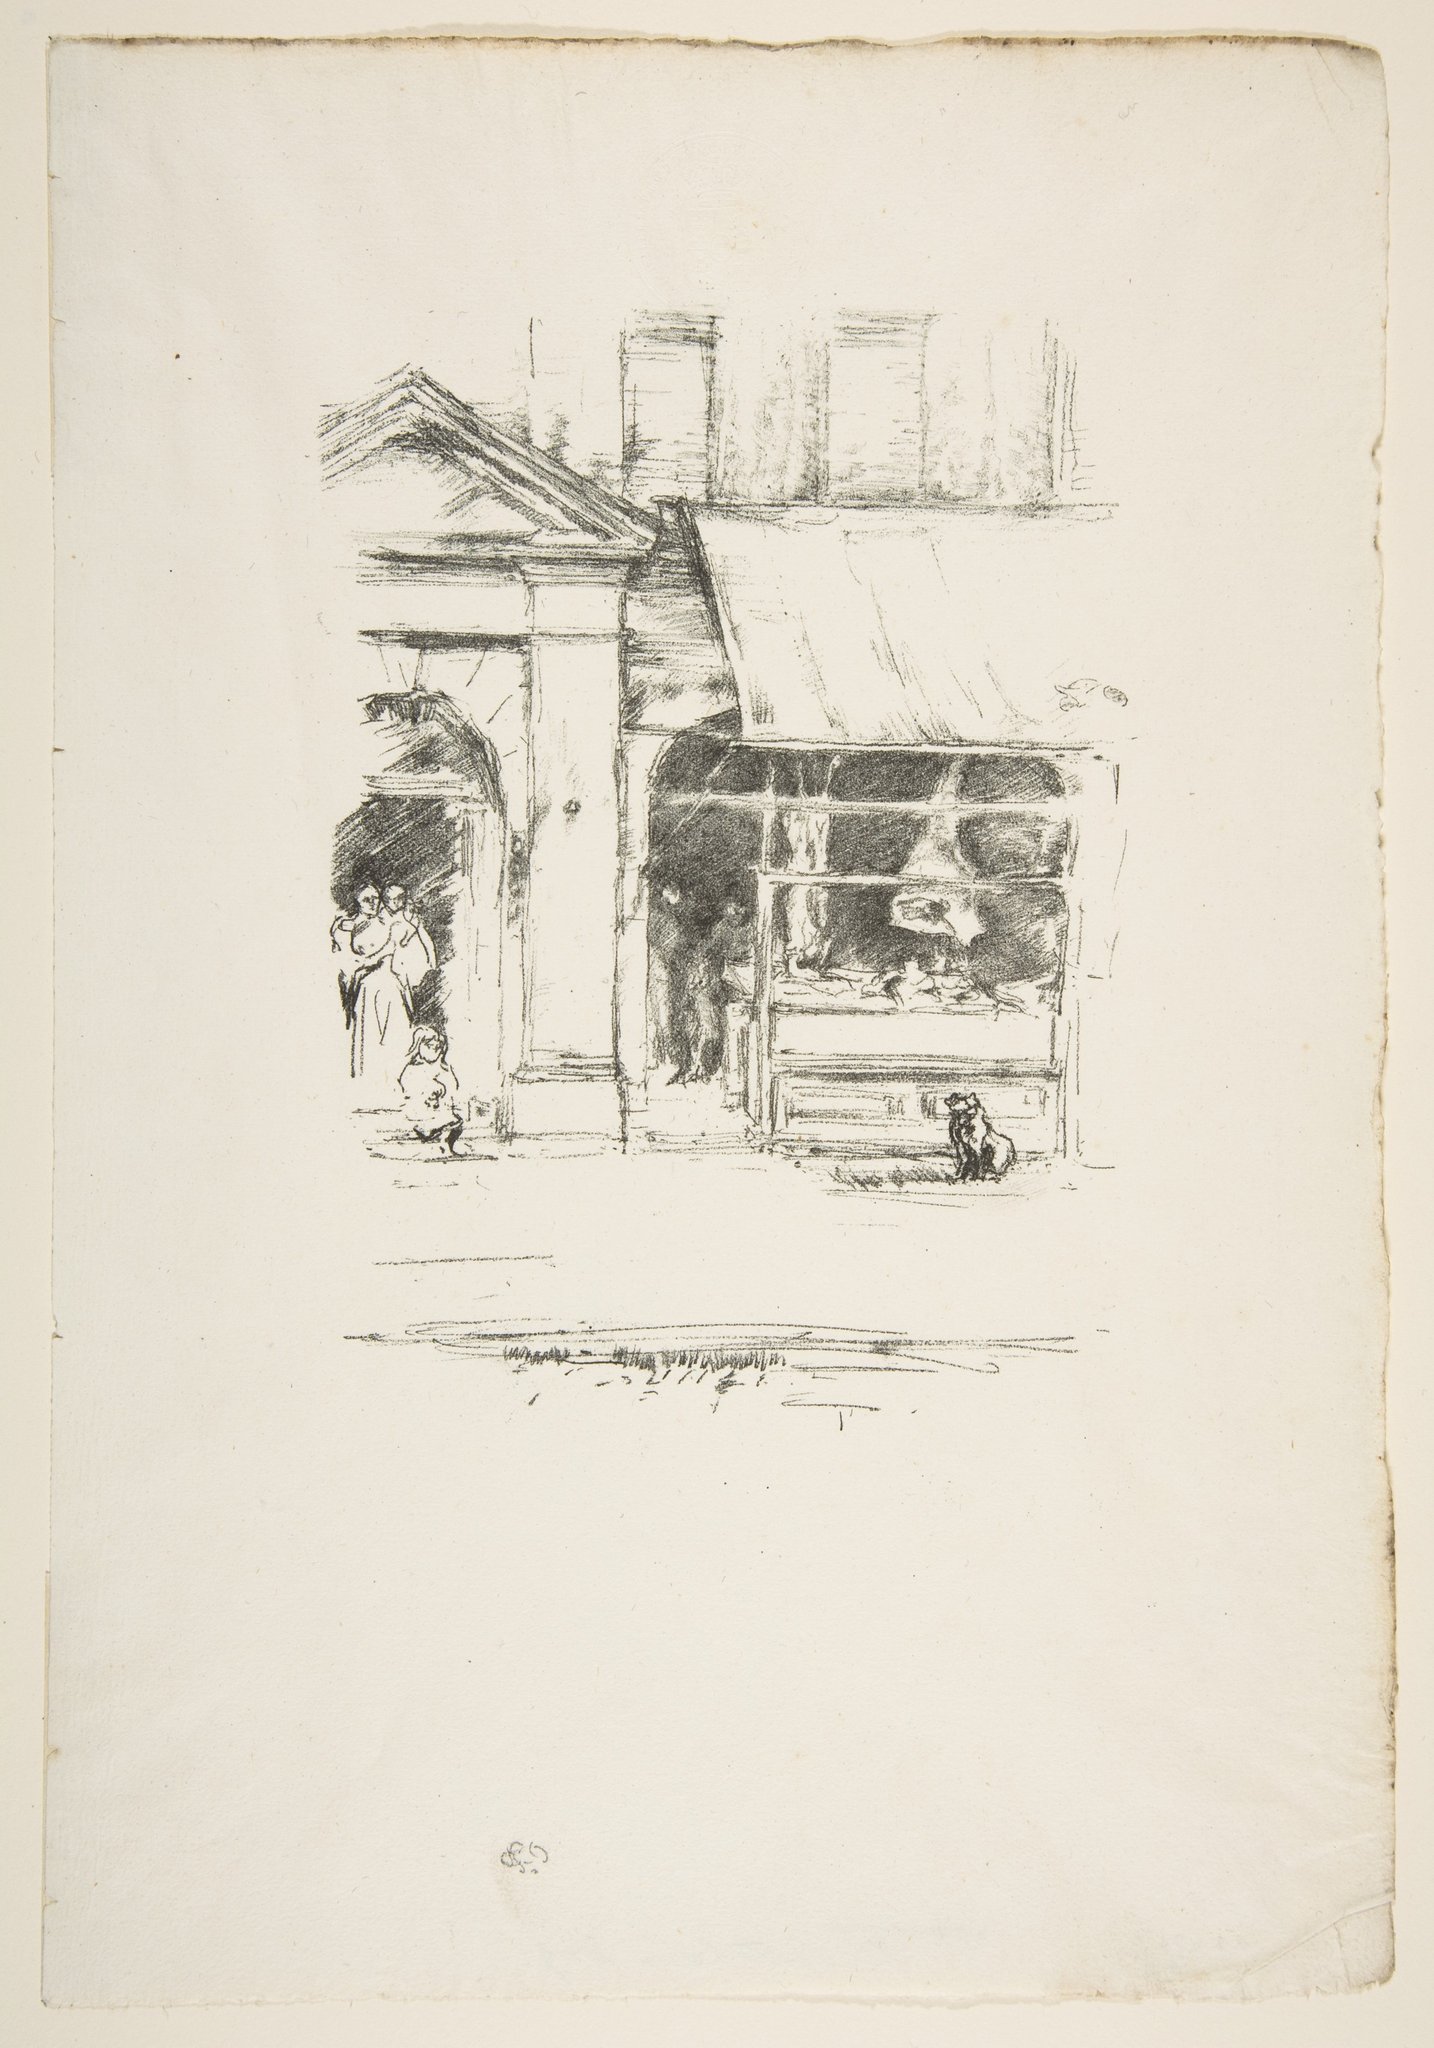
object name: print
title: The Butcher's Dog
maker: james mcneill whistler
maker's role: artist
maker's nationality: american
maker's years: 1834-1903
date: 1896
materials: ink, paper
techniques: printing, lithography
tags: human figures,dogs,butchers